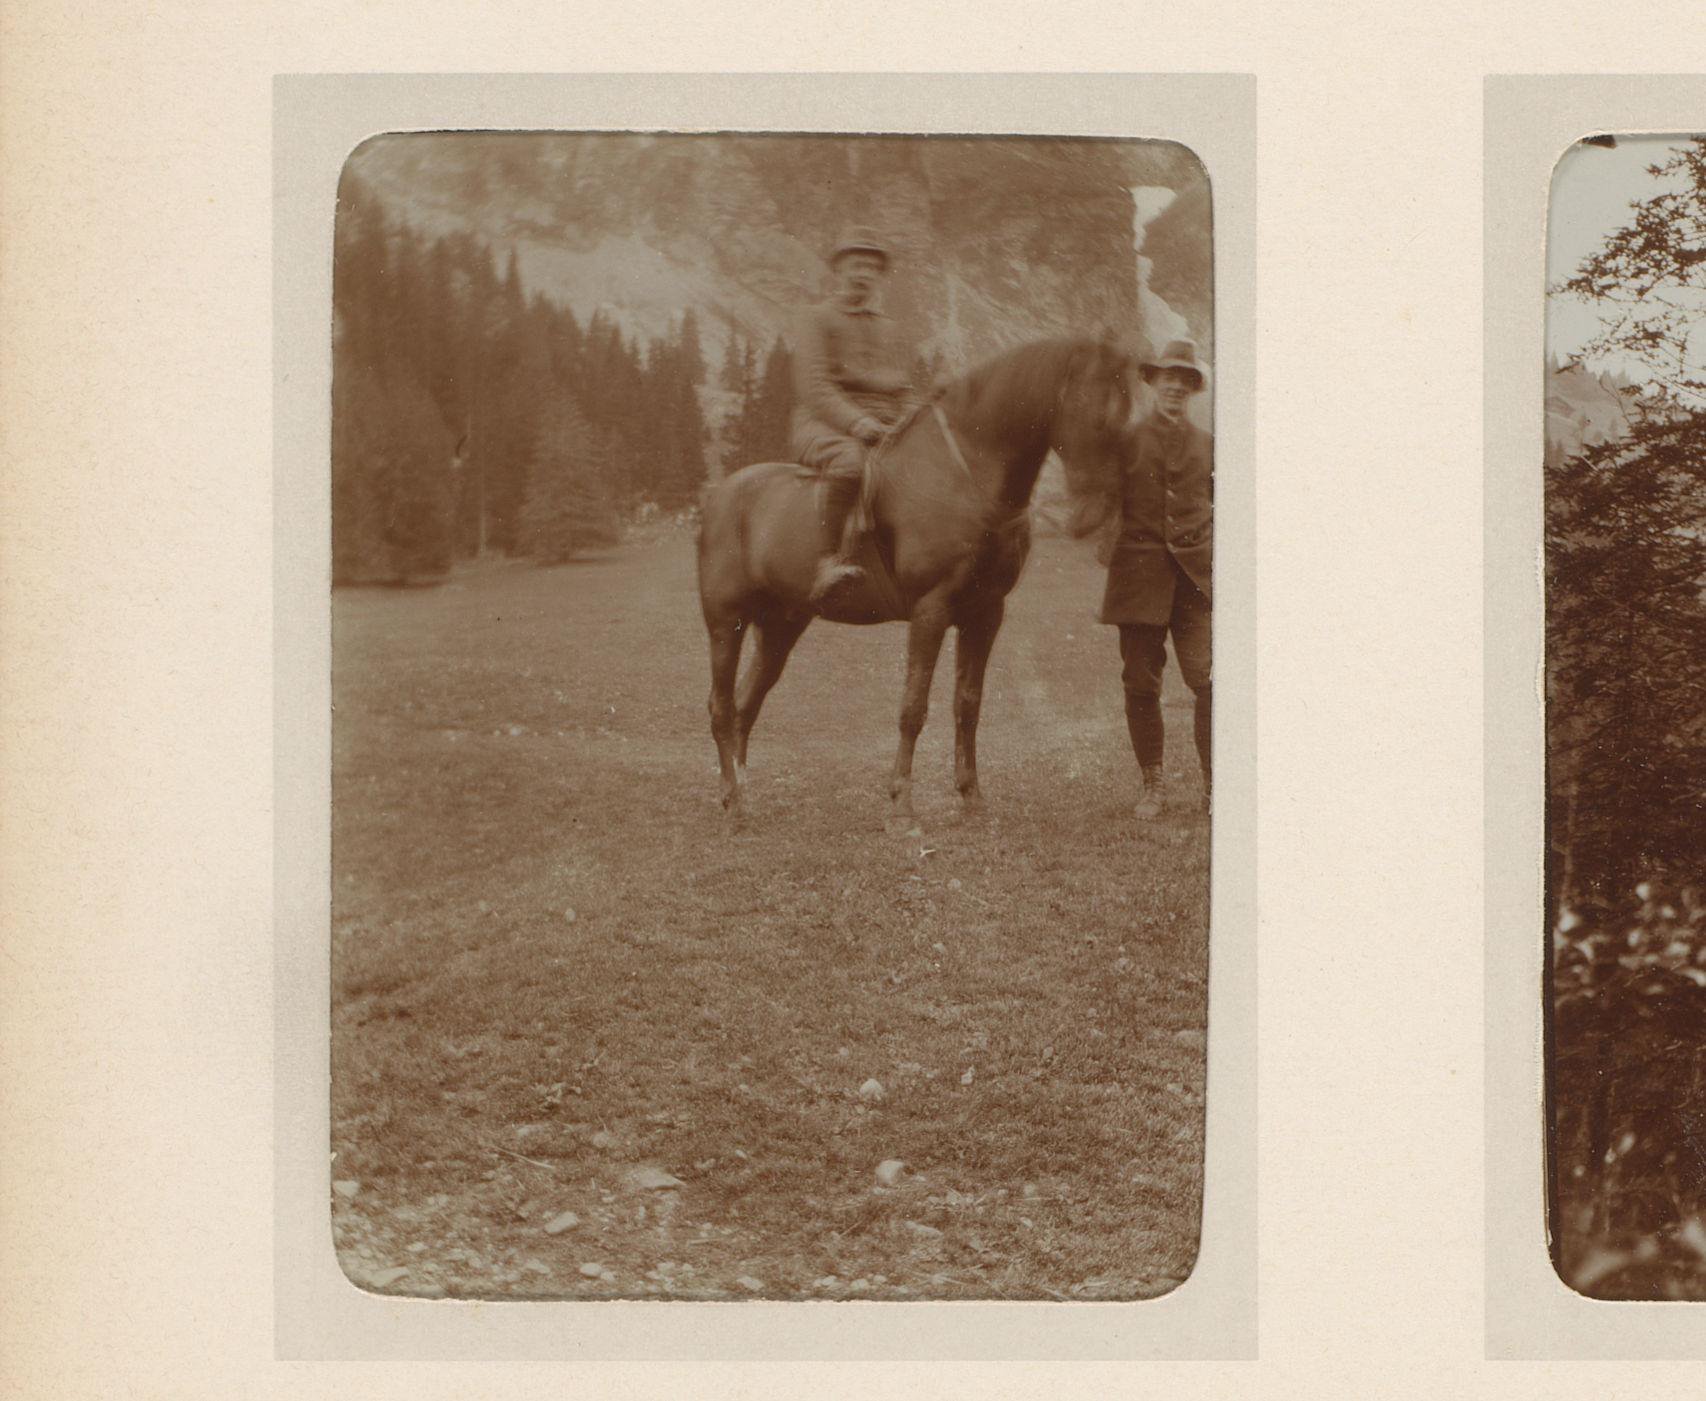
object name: album leaf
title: Man te paard en een man ernaast op een bergwei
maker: liesbeth overhoff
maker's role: fotograaf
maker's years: 1895-1969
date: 1911-1912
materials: paper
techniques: gelatin silver print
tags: riding a horse, ass, or mule; rider, horseman, meadow, pasture, mountains